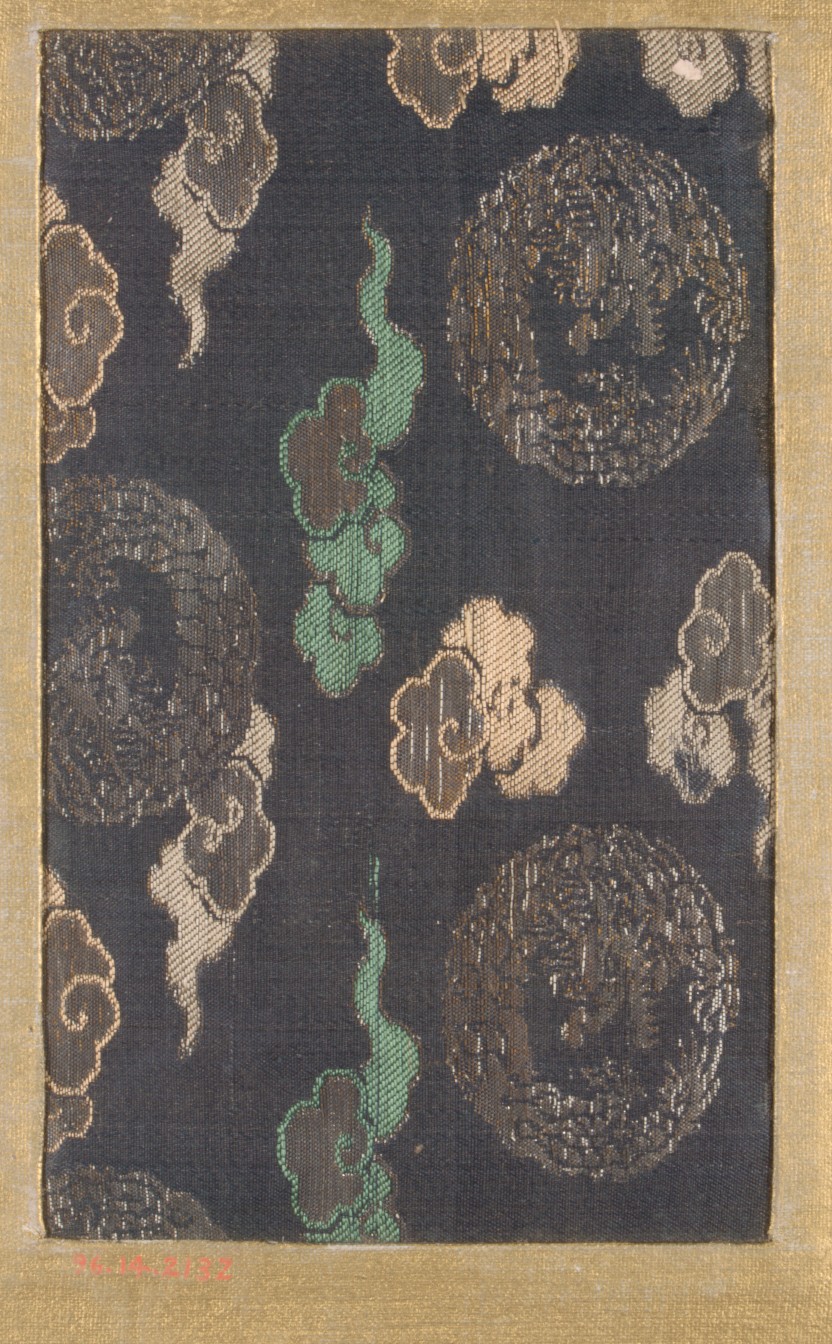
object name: piece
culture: japanese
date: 1701-1900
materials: silk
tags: dragons,clouds